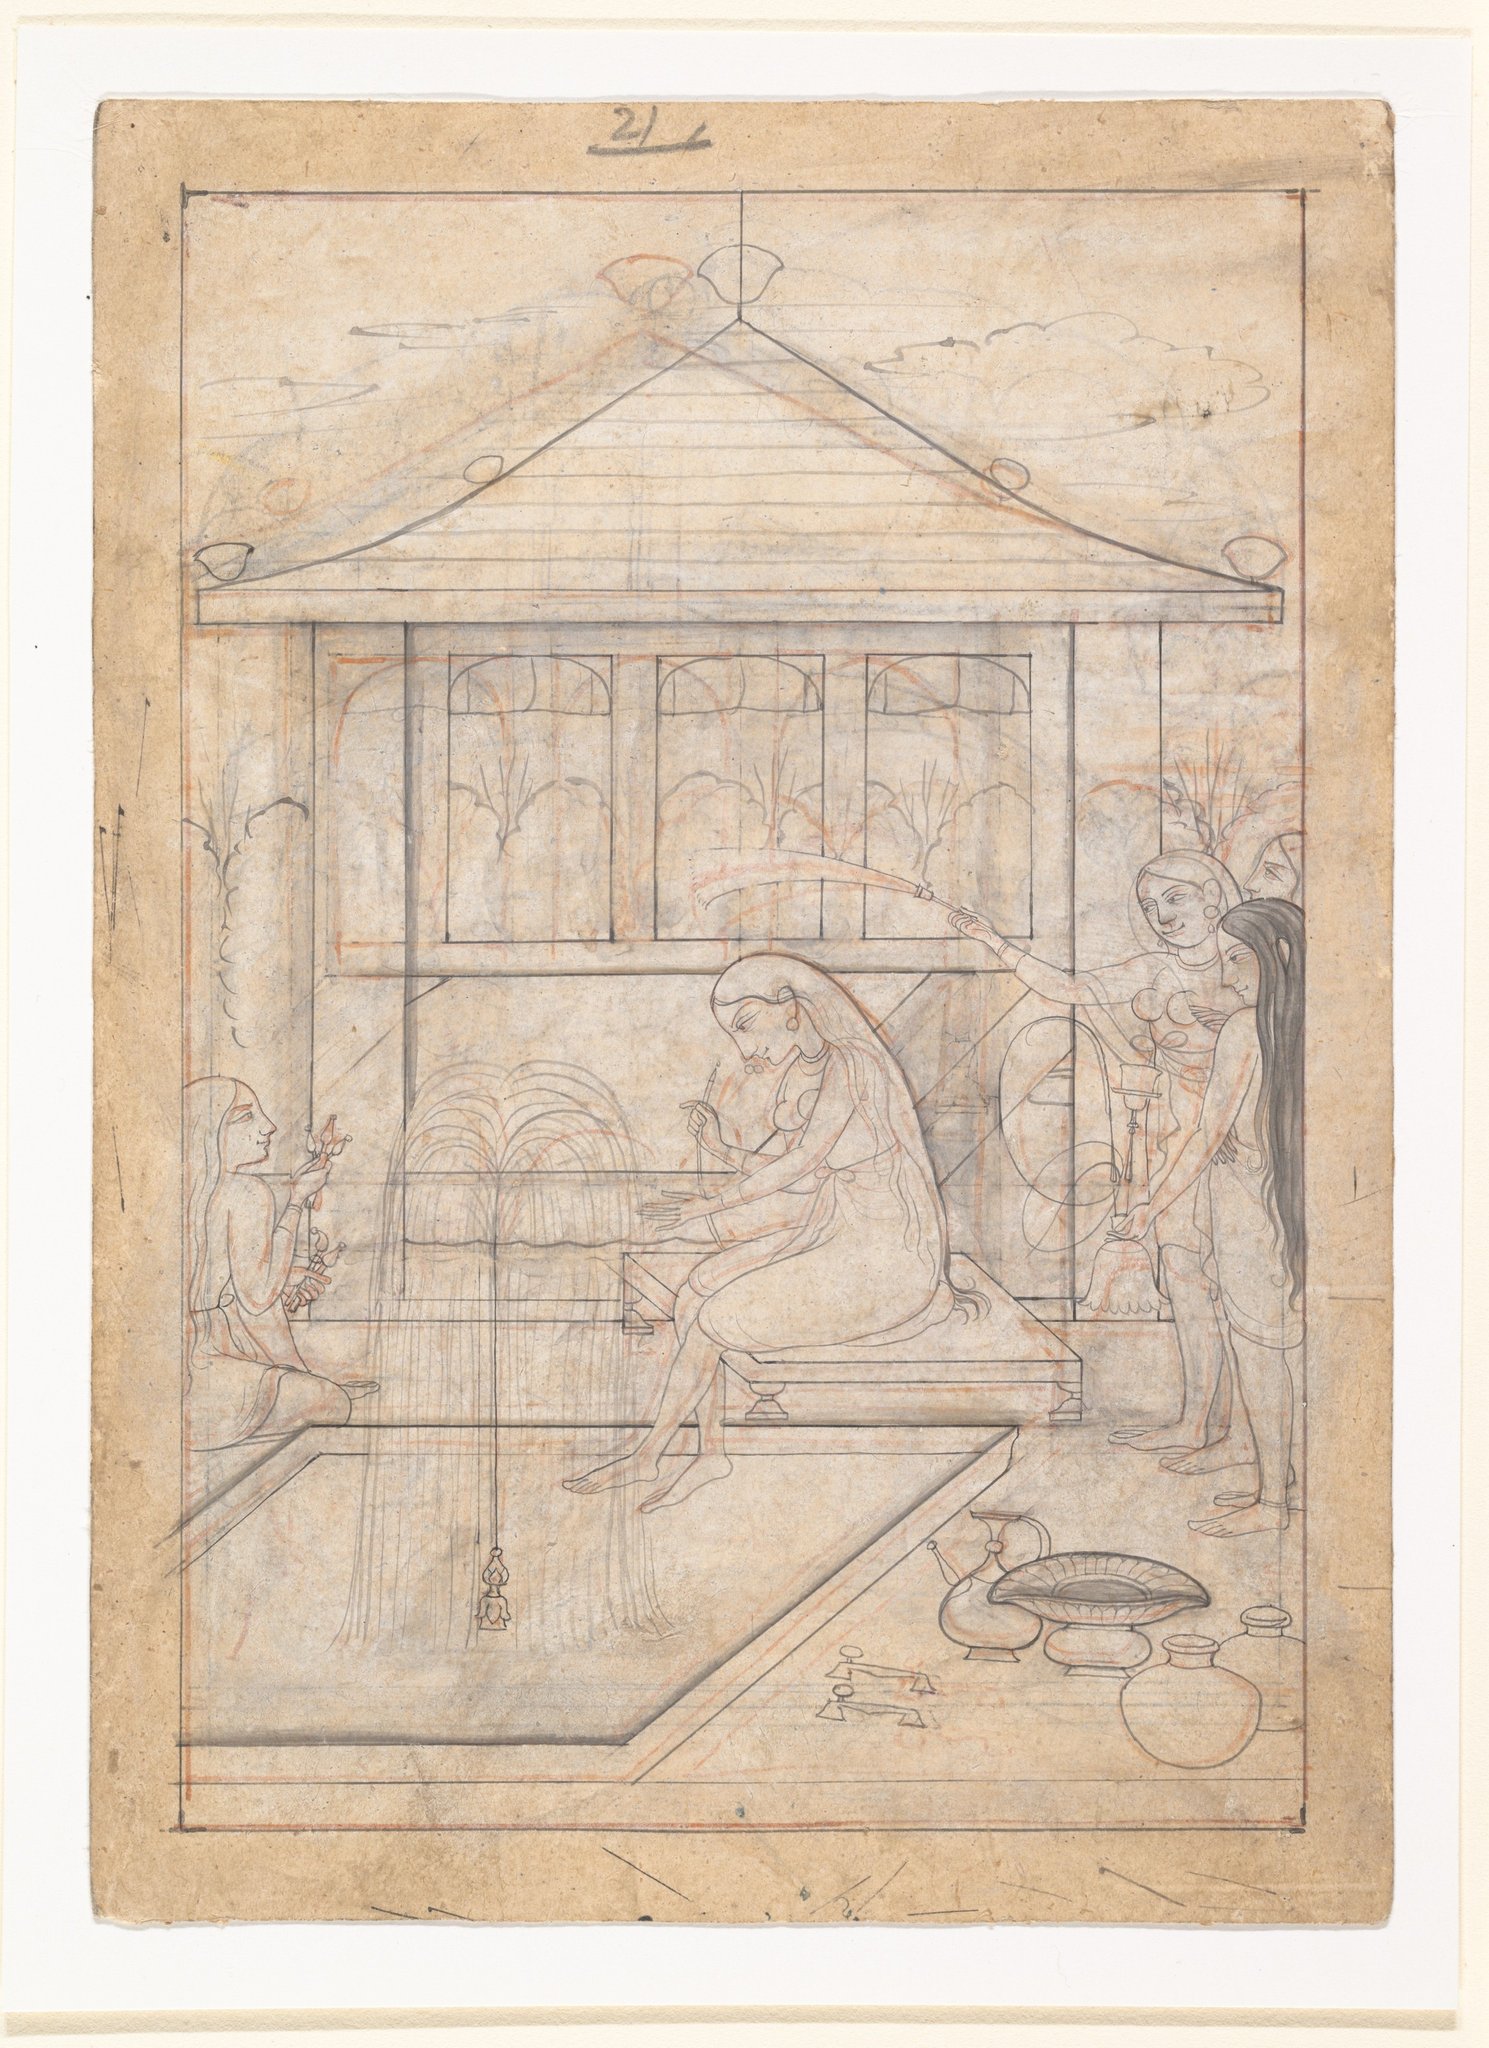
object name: drawing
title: Lady About to Smoke a Hookah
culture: indian, kangra, punjab hills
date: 1790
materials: ink, paper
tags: fountains,women,smoking,hookah